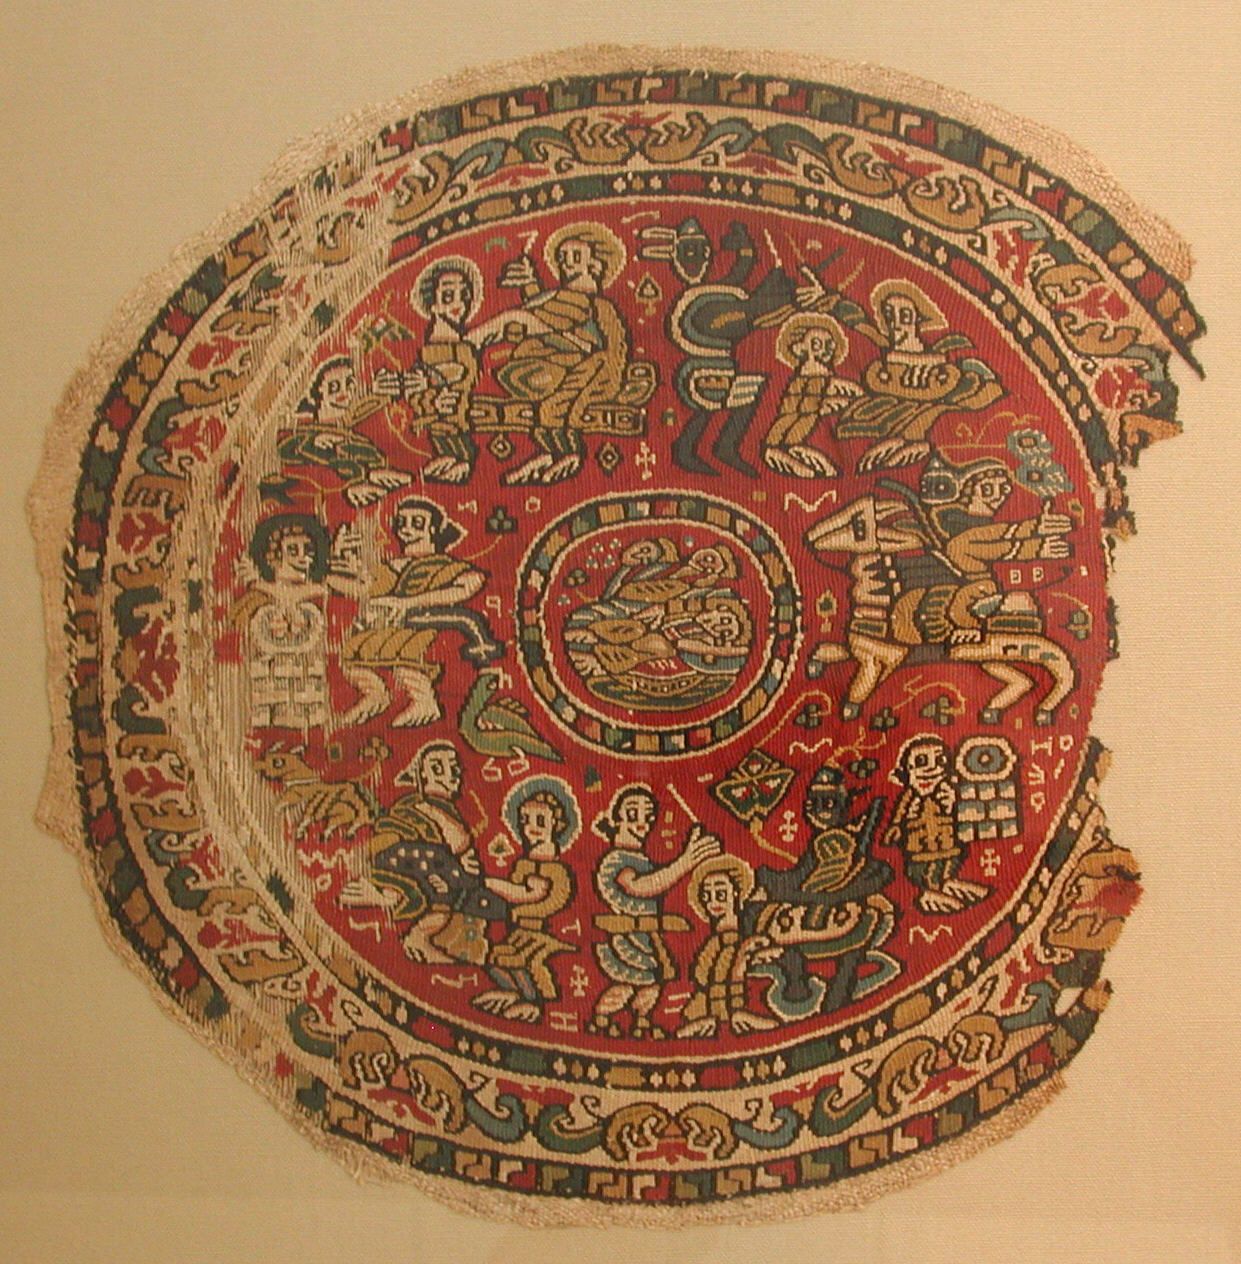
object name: roundel fragment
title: Roundel Illustrating Episodes from the Biblical Story of Joseph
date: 601-700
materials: linen, wool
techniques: weave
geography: egypt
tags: men